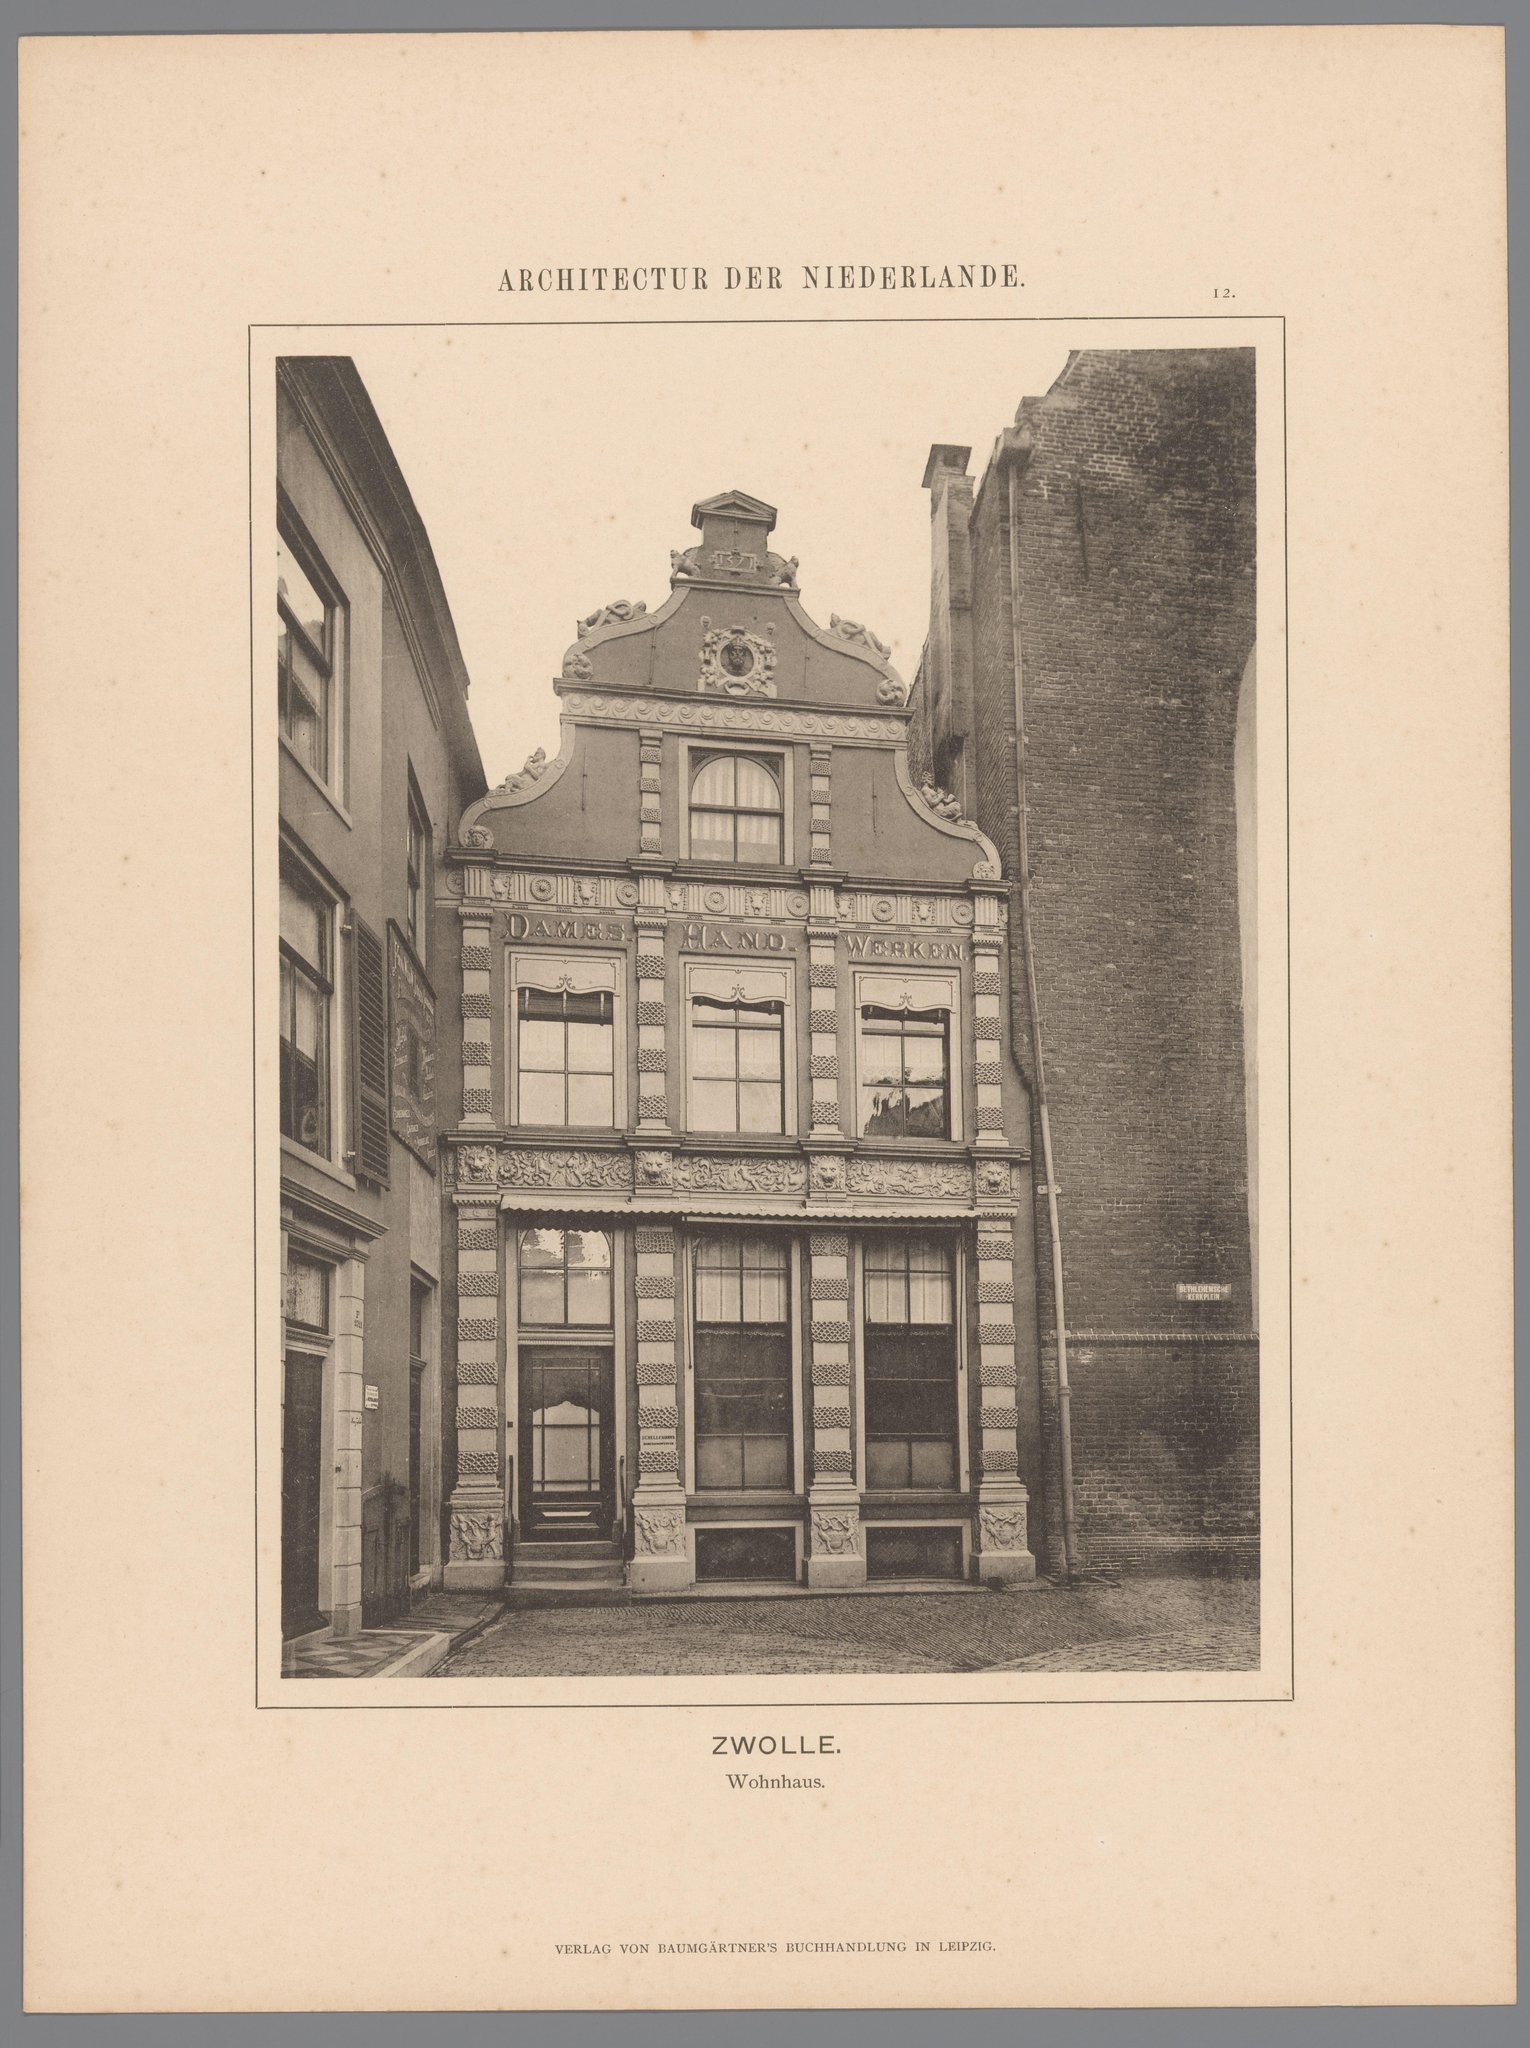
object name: photomechanical print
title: Architectur der Niederlande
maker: Anonymous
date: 1894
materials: paper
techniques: photograph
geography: leipzig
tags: urban housing, façade (of house or building)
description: Afdruk uit: Krook, L. Architectur der Niederlande. Leipzig: Baumgärtner's Buchhandlung, 1894.